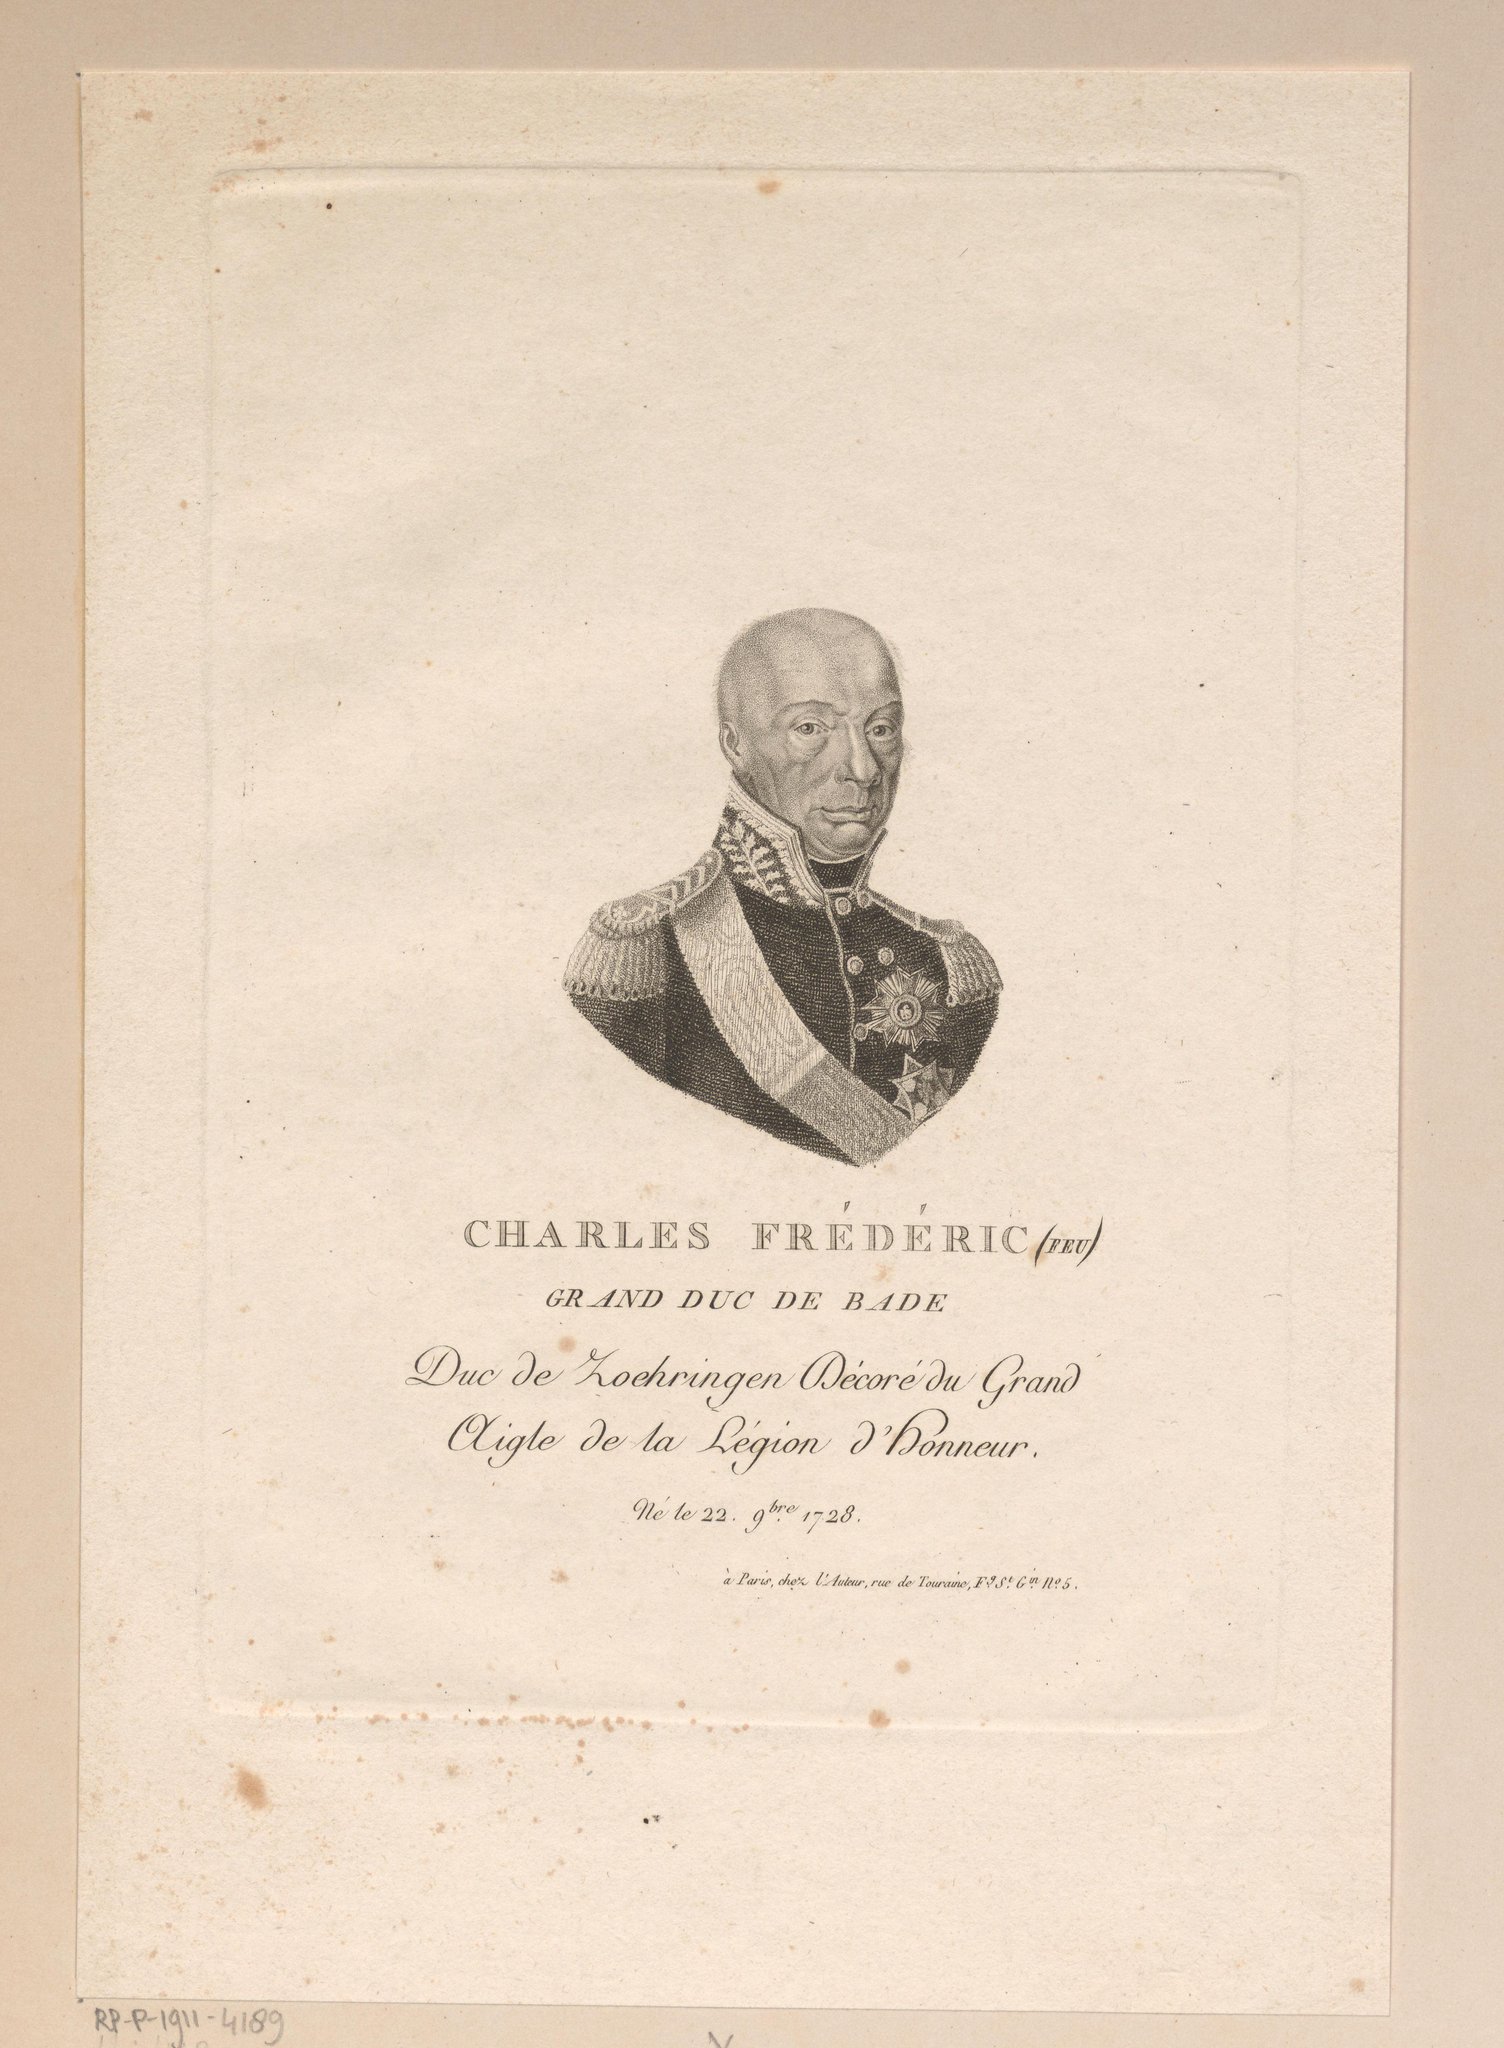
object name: print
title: Collection complète des portraits des Grands-Aigles et des Grands-Officiers de la Légion d'Honneur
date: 1810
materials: paper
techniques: engraving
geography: paris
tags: historical persons, medals and other marks of military honour, ruler, sovereign